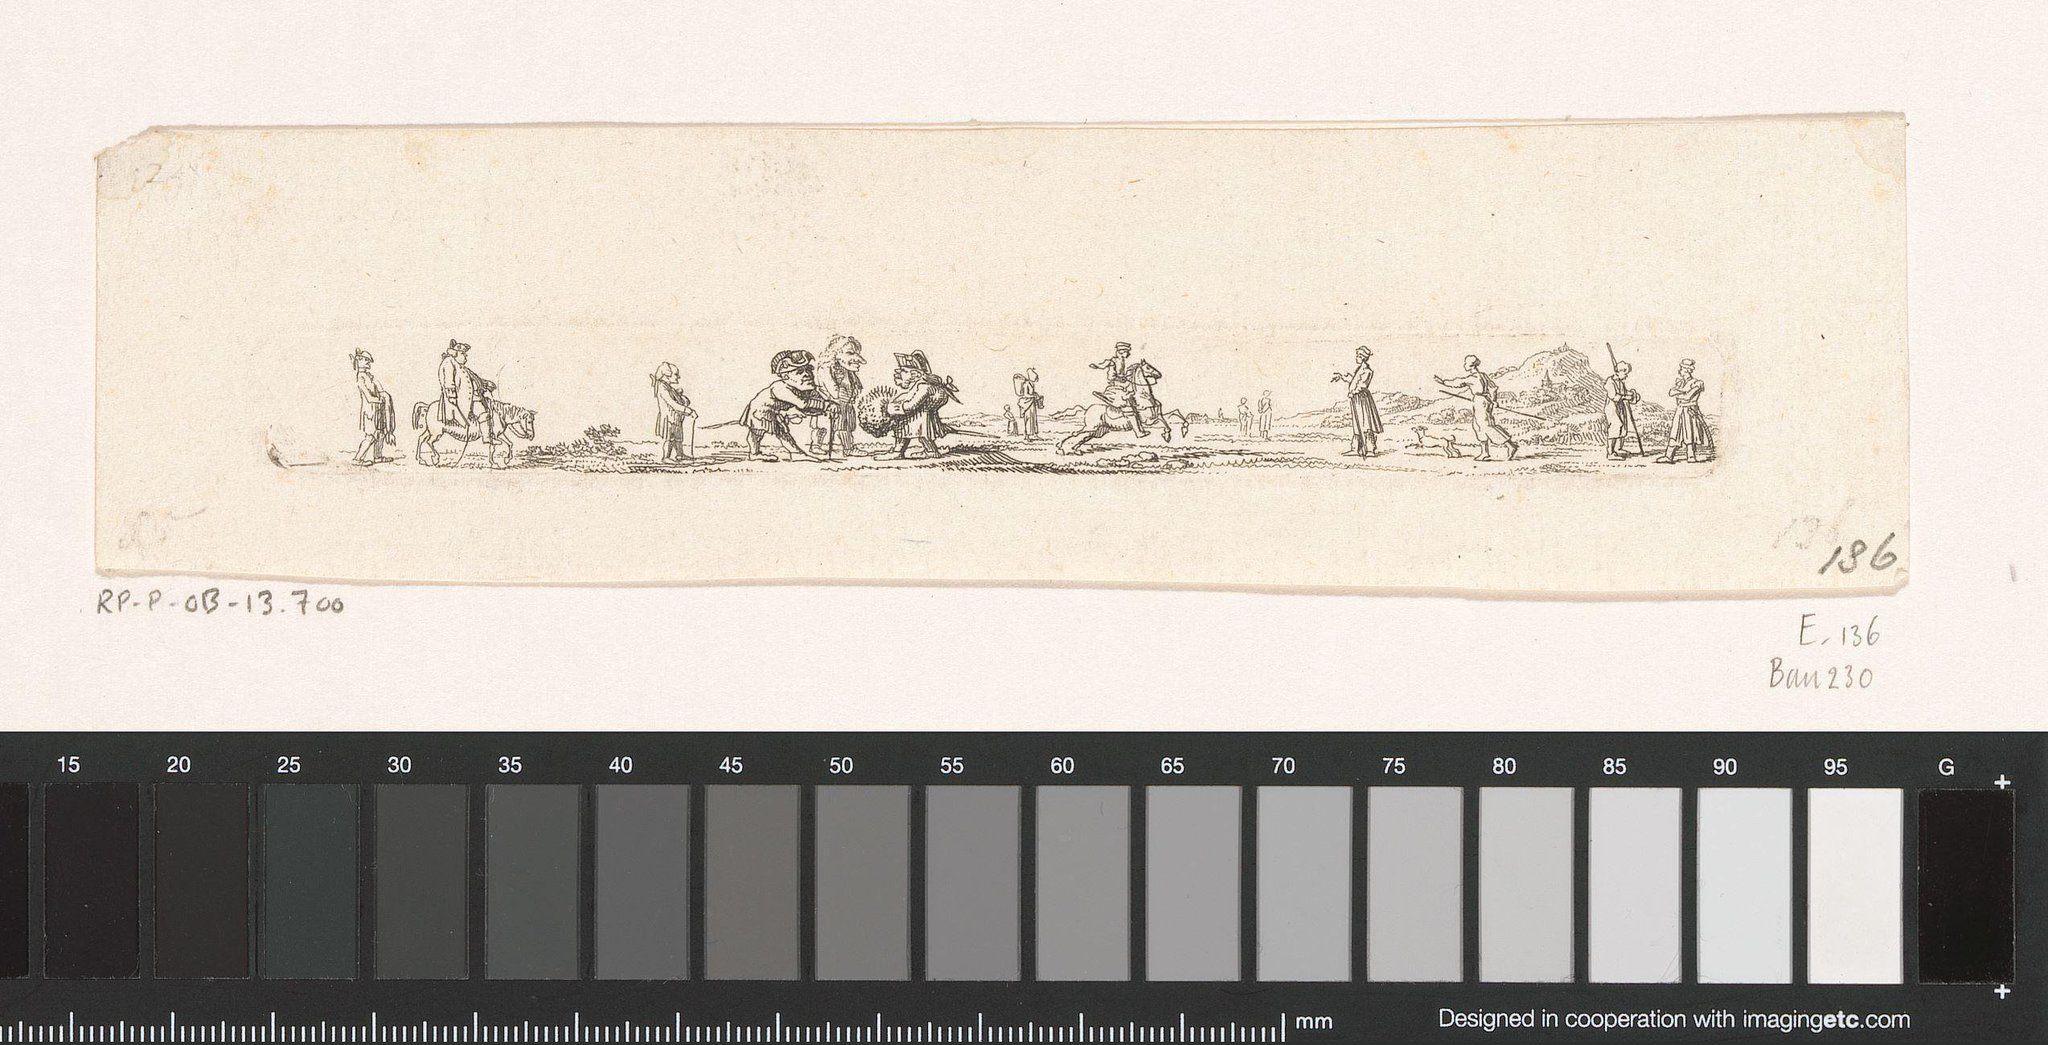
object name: print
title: Karikaturen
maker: daniel nikolaus chodowiecki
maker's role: draughtsman, print maker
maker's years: 1726-1801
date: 1775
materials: paper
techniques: etching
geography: berlin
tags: riding a horse, ass, or mule; rider, horseman, caricatures (human types), hunchback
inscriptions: collector's mark: Lugt 2228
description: Onder meer een dikke man op een paard, drie converserende bochelige mannen en een ruiter.